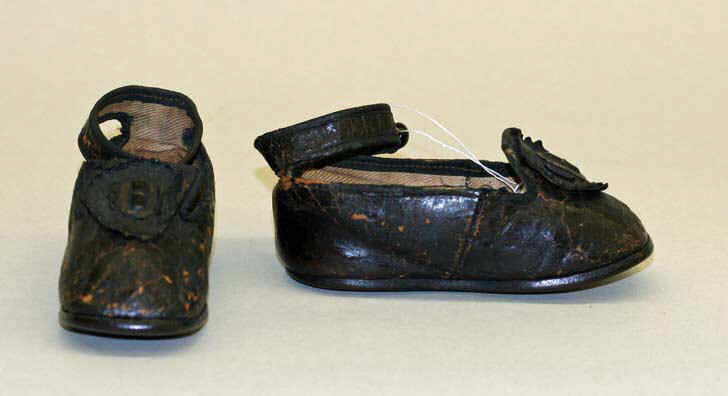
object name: slipper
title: Slippers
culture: american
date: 1860-1880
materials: leather